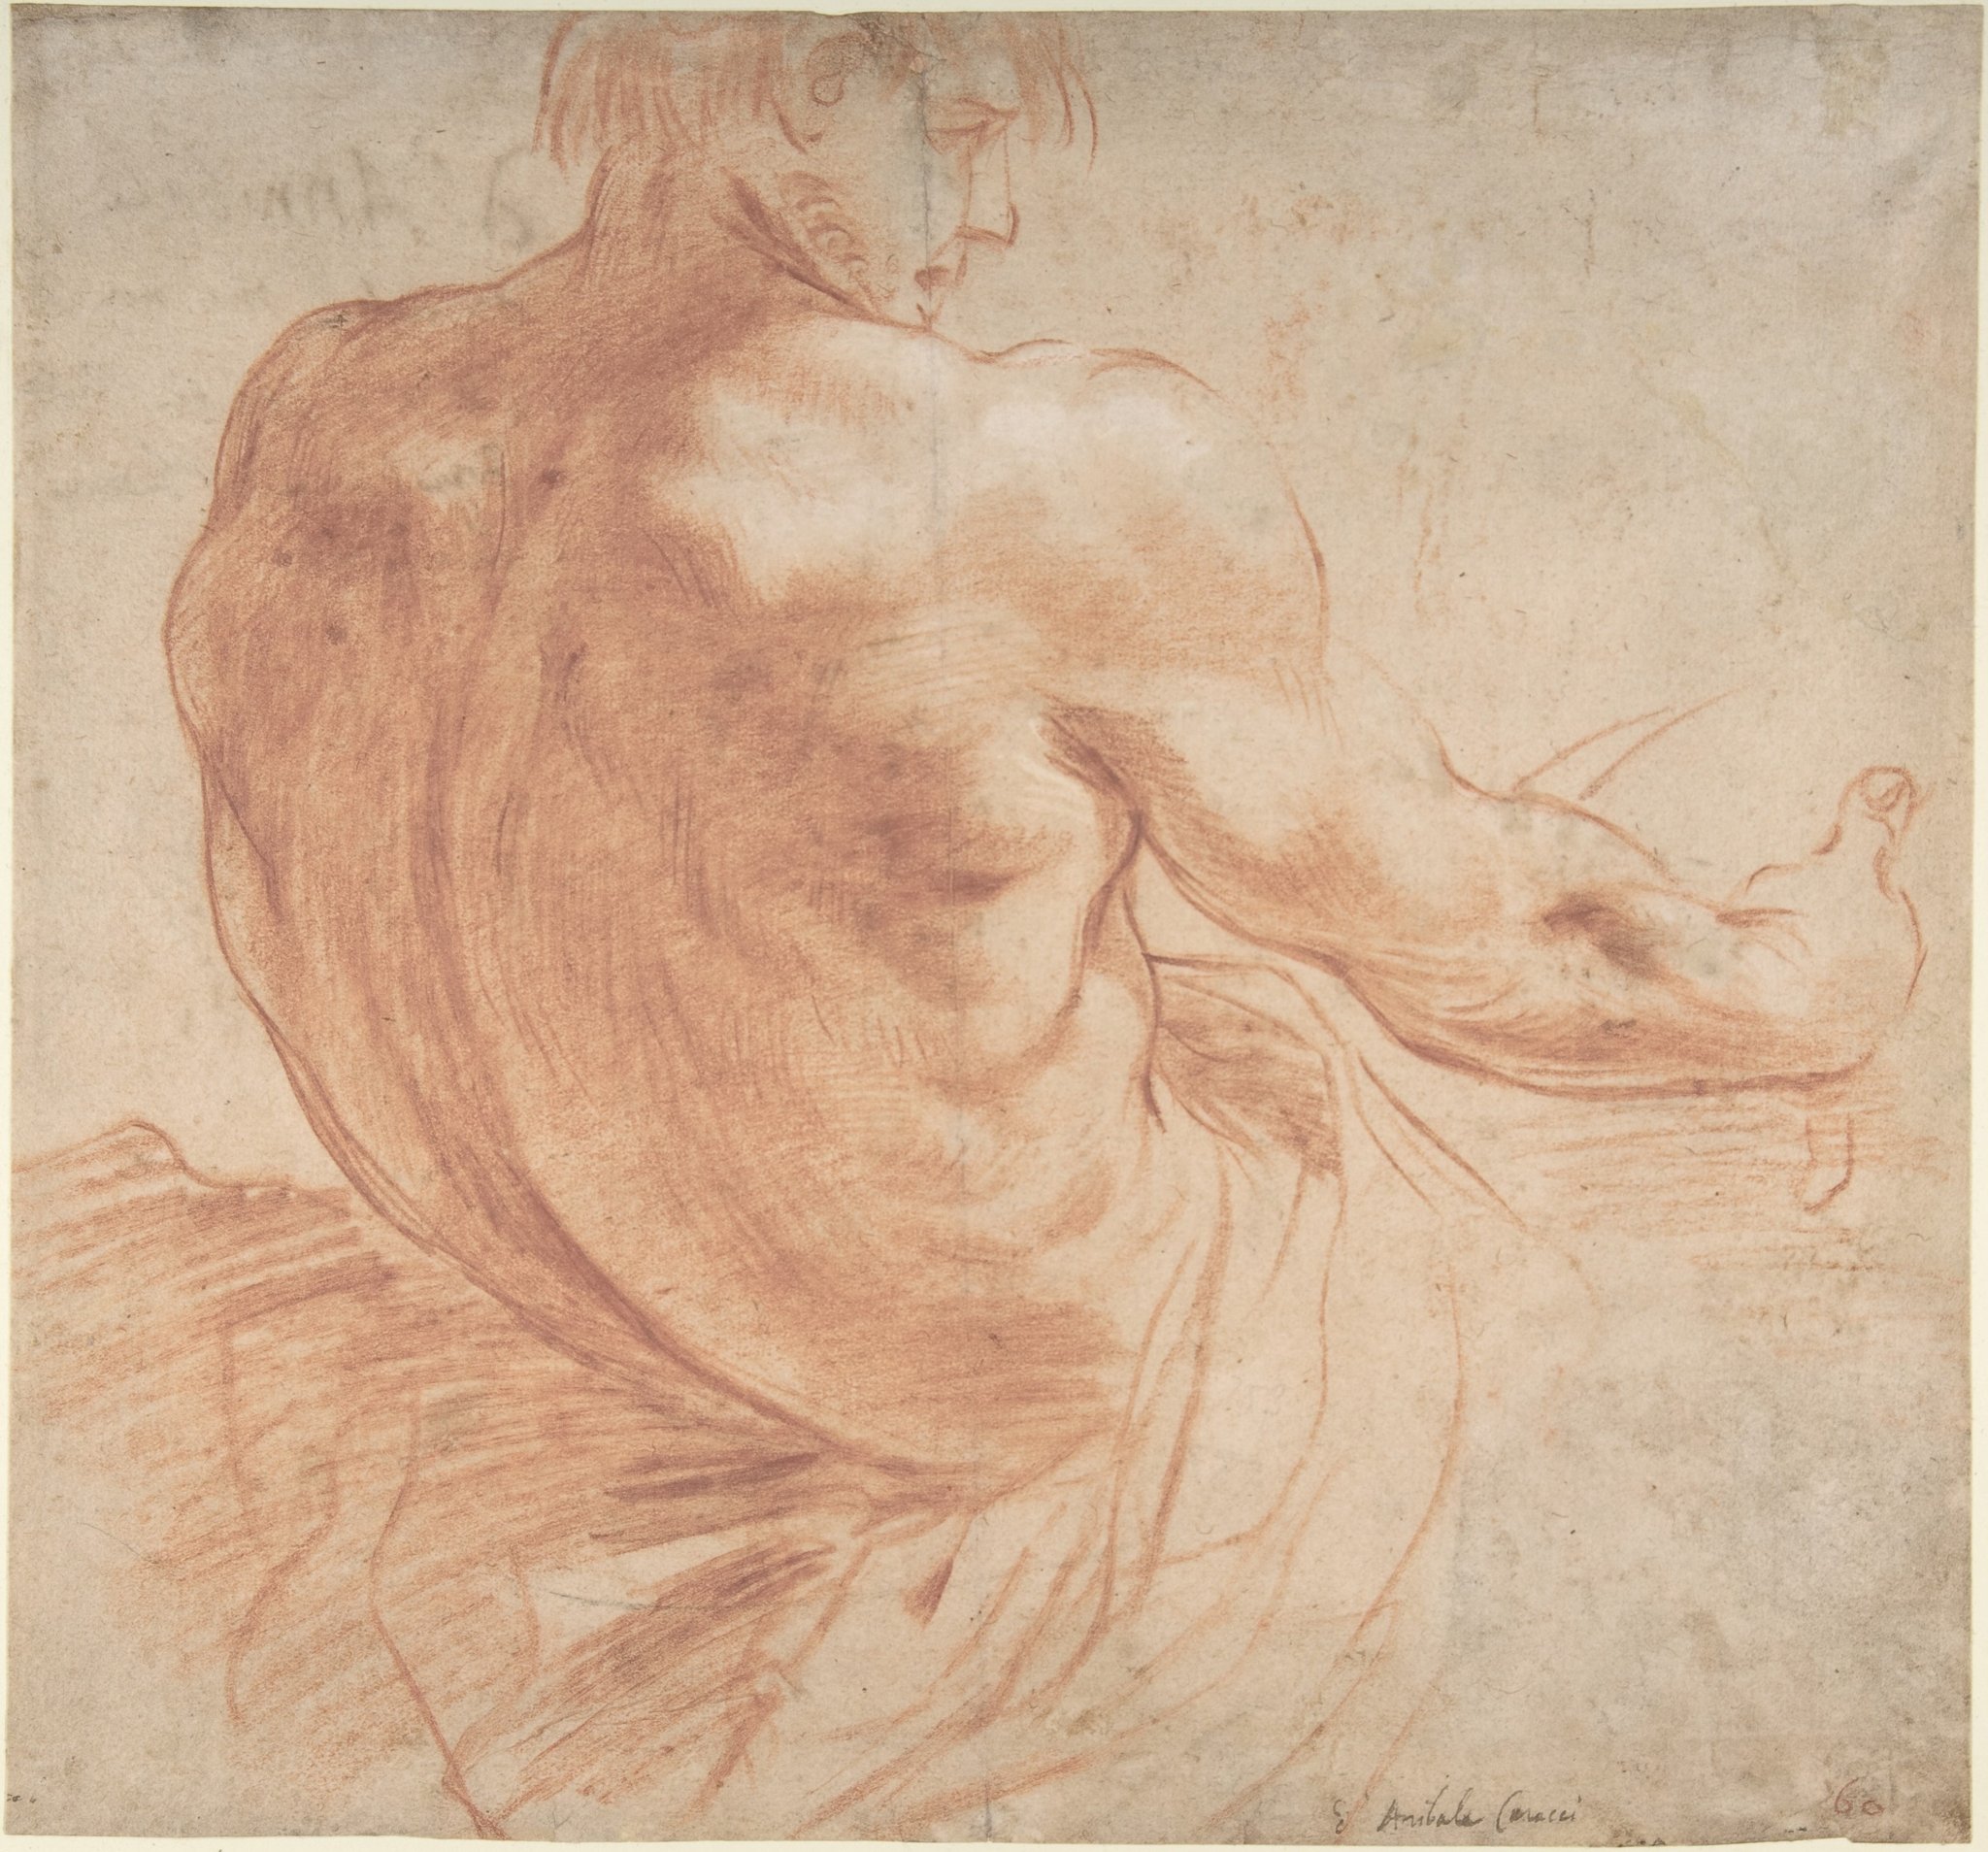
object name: drawing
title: Seated Youth Facing Right, Seen from the Back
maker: annibale carracci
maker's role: artist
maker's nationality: italian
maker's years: 1560-1609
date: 1560-1609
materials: chalk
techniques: highlighting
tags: men